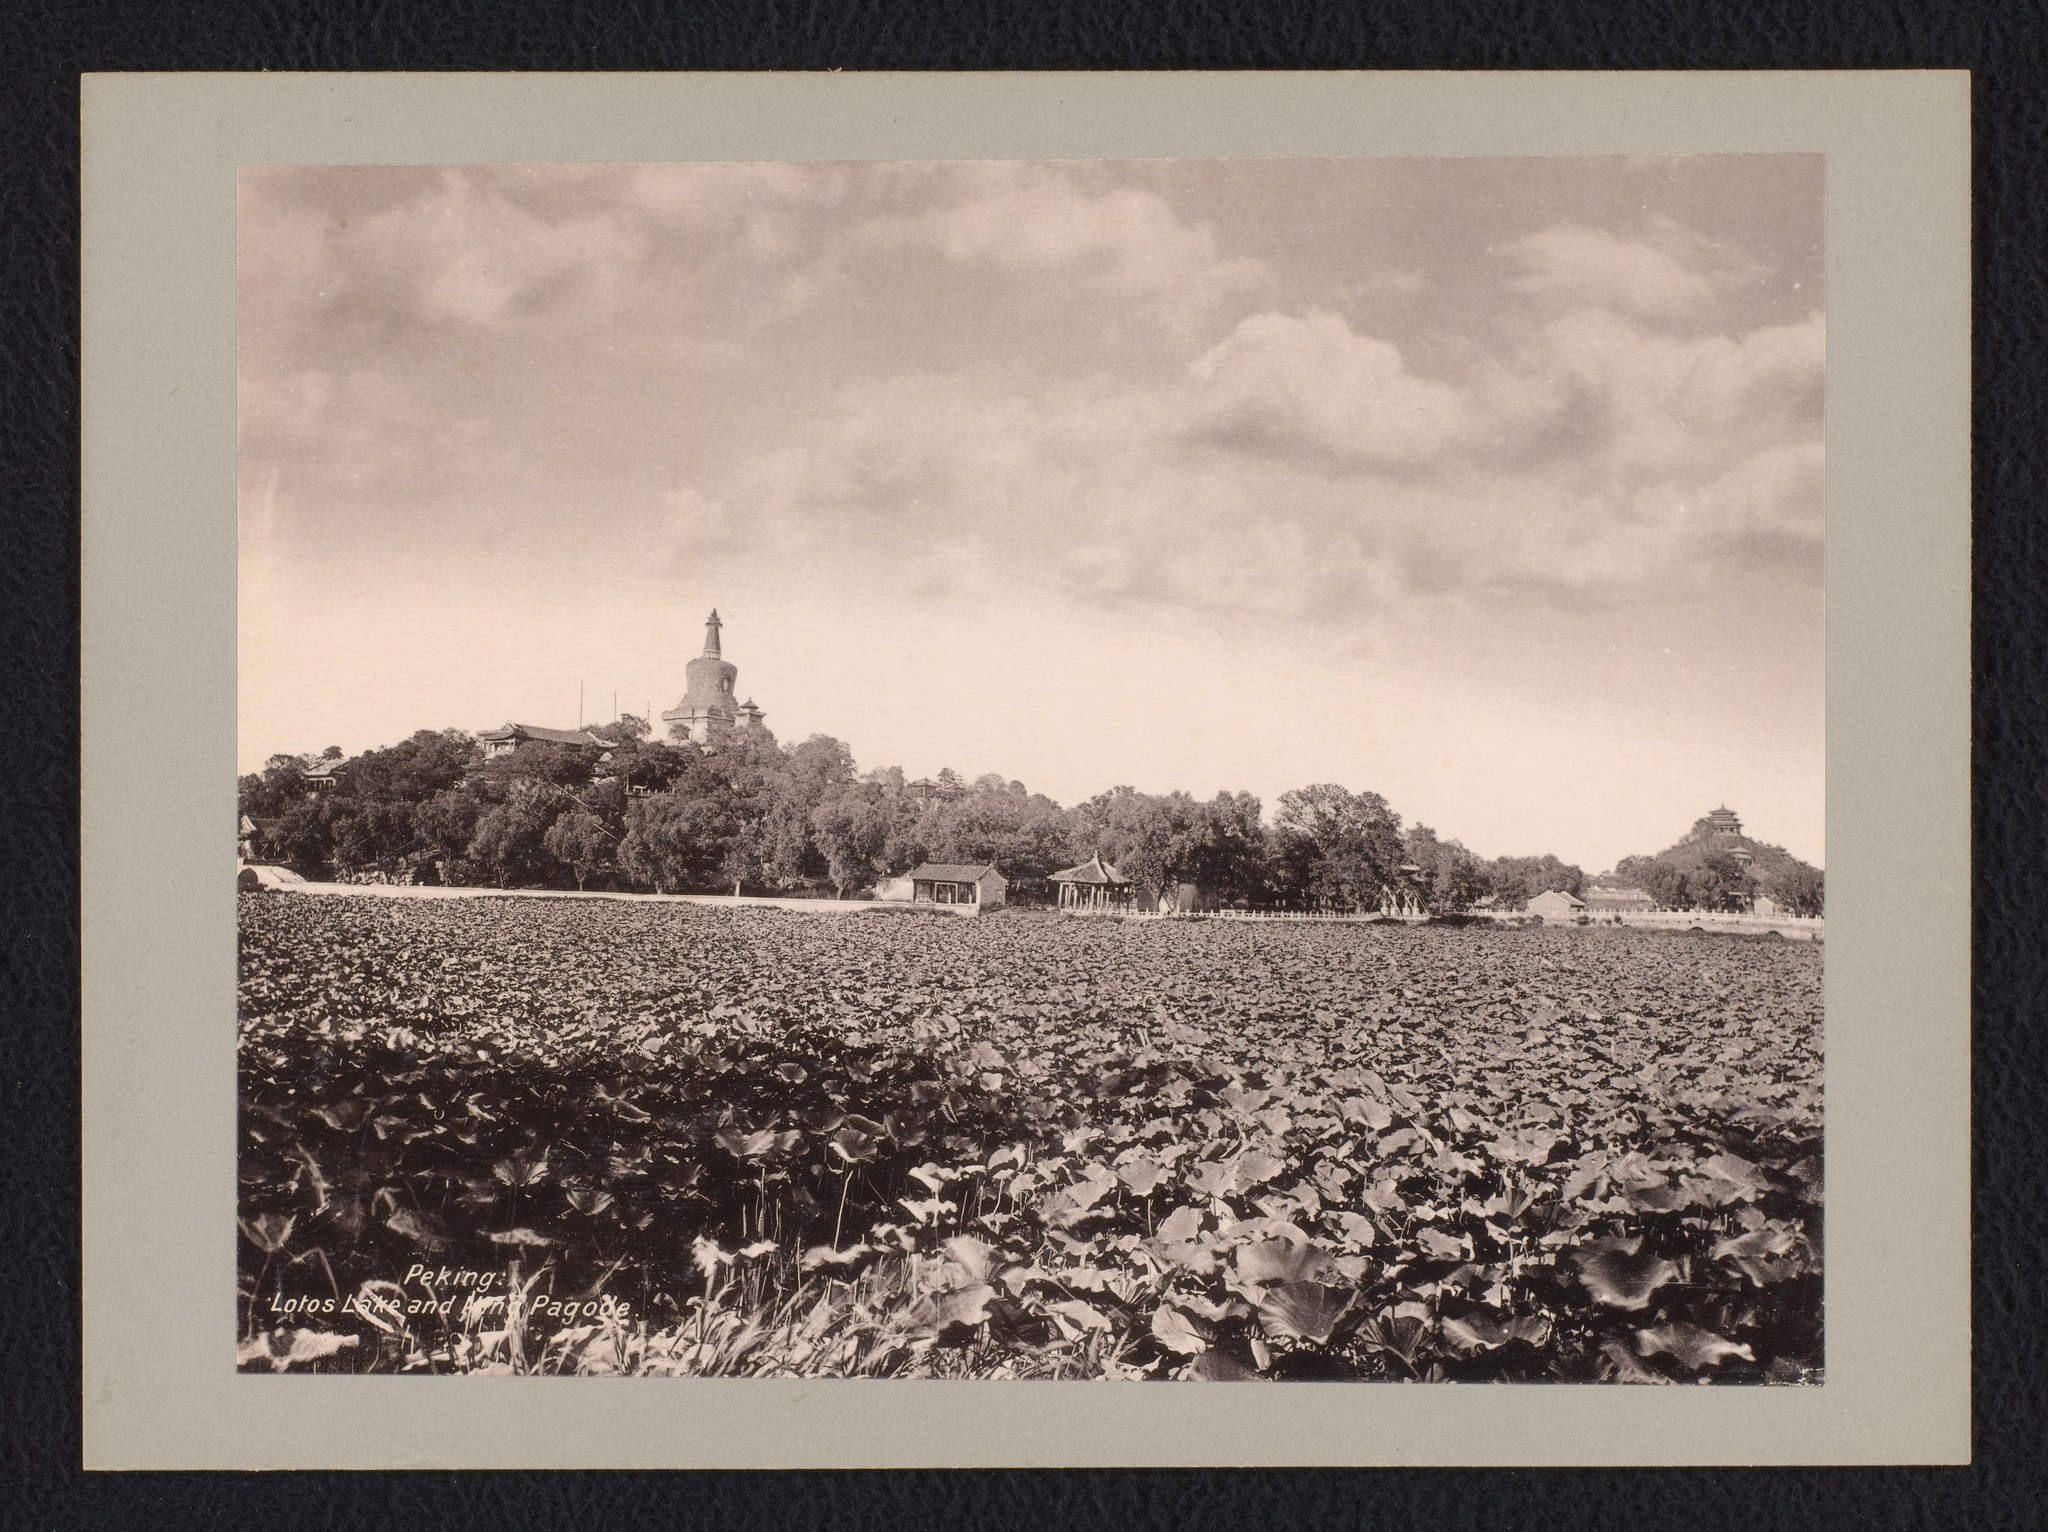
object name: photograph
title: Peking: Lotos Lake and Ming Pagode.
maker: Anonymous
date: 1895-1915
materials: cardboard, photographic support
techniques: photograph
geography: beijing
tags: peking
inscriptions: number: ‘13.’